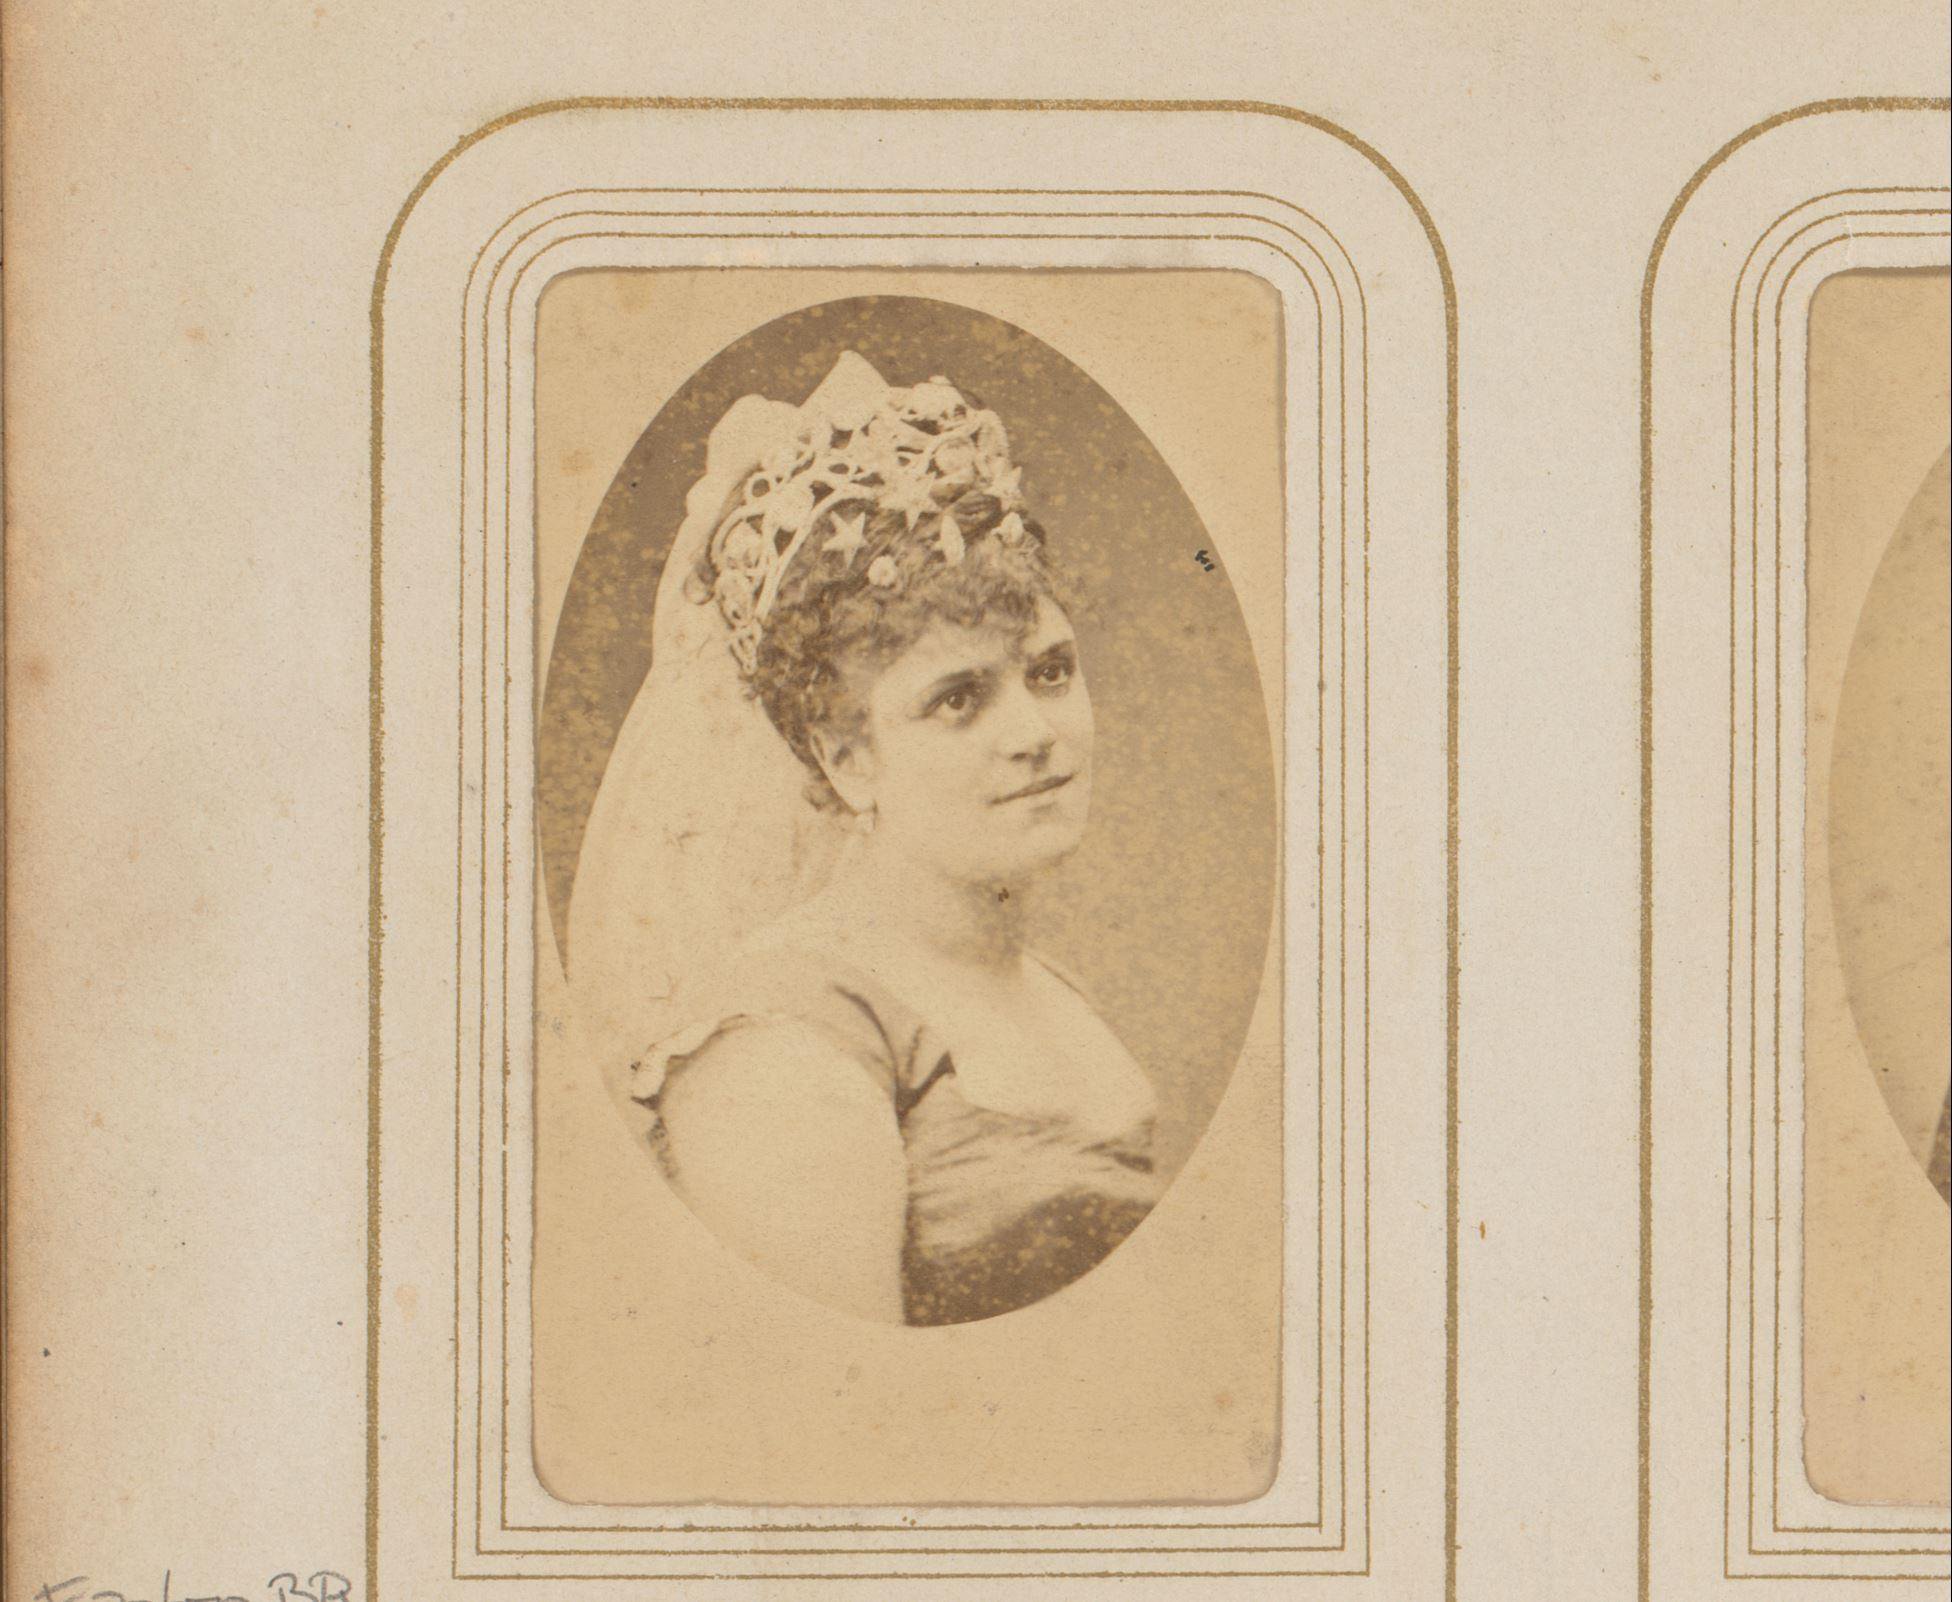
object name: photograph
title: Portret van een vrouw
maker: Anonymous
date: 1860-1880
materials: cardboard, photographic support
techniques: albumen print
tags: historical persons - bb - woman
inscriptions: annotation: ‘Andre’, annotation: ‘André’